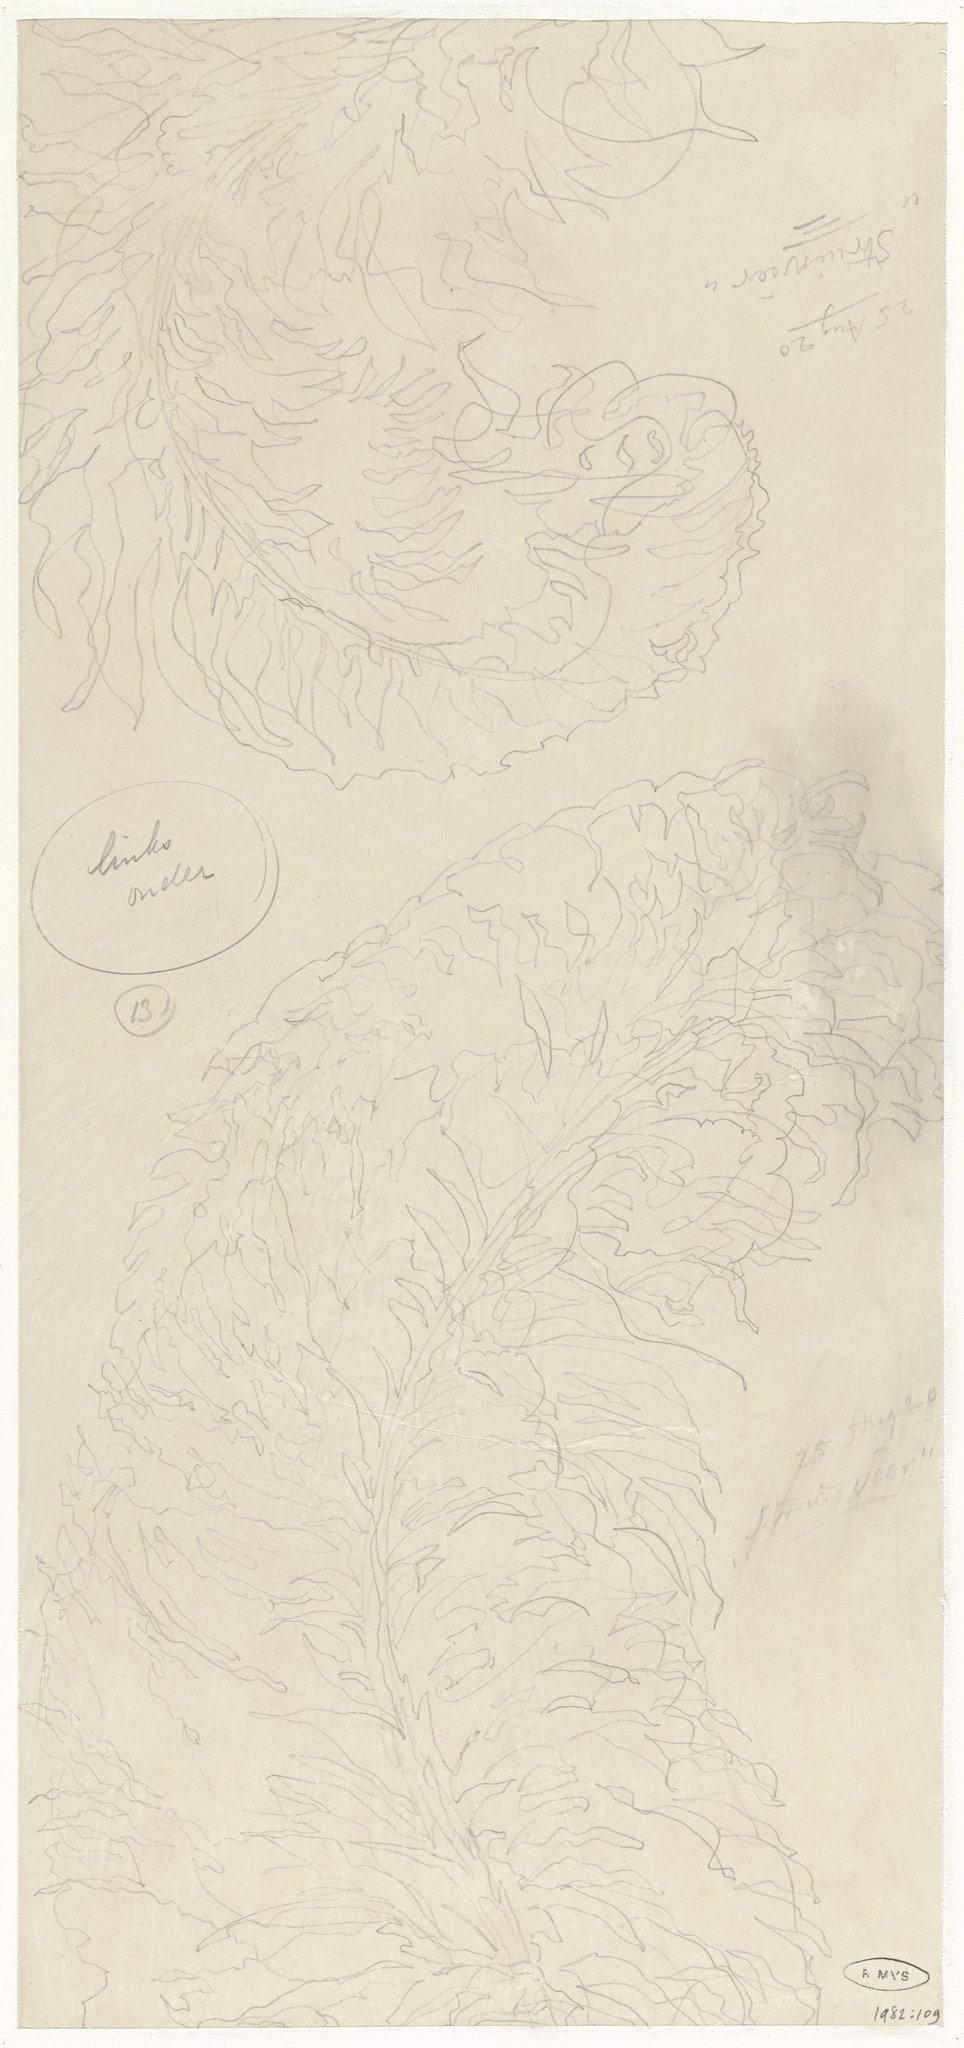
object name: design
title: Ontwerp voor aardewerkdecoratie: struisveren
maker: theo colenbrander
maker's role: draughtsman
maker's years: 1841-1930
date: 1920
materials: paper, pencil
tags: walker and runner birds: ostrich (+ feathers), other ornament derived from animal forms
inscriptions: date: ‘25 Aug 20’